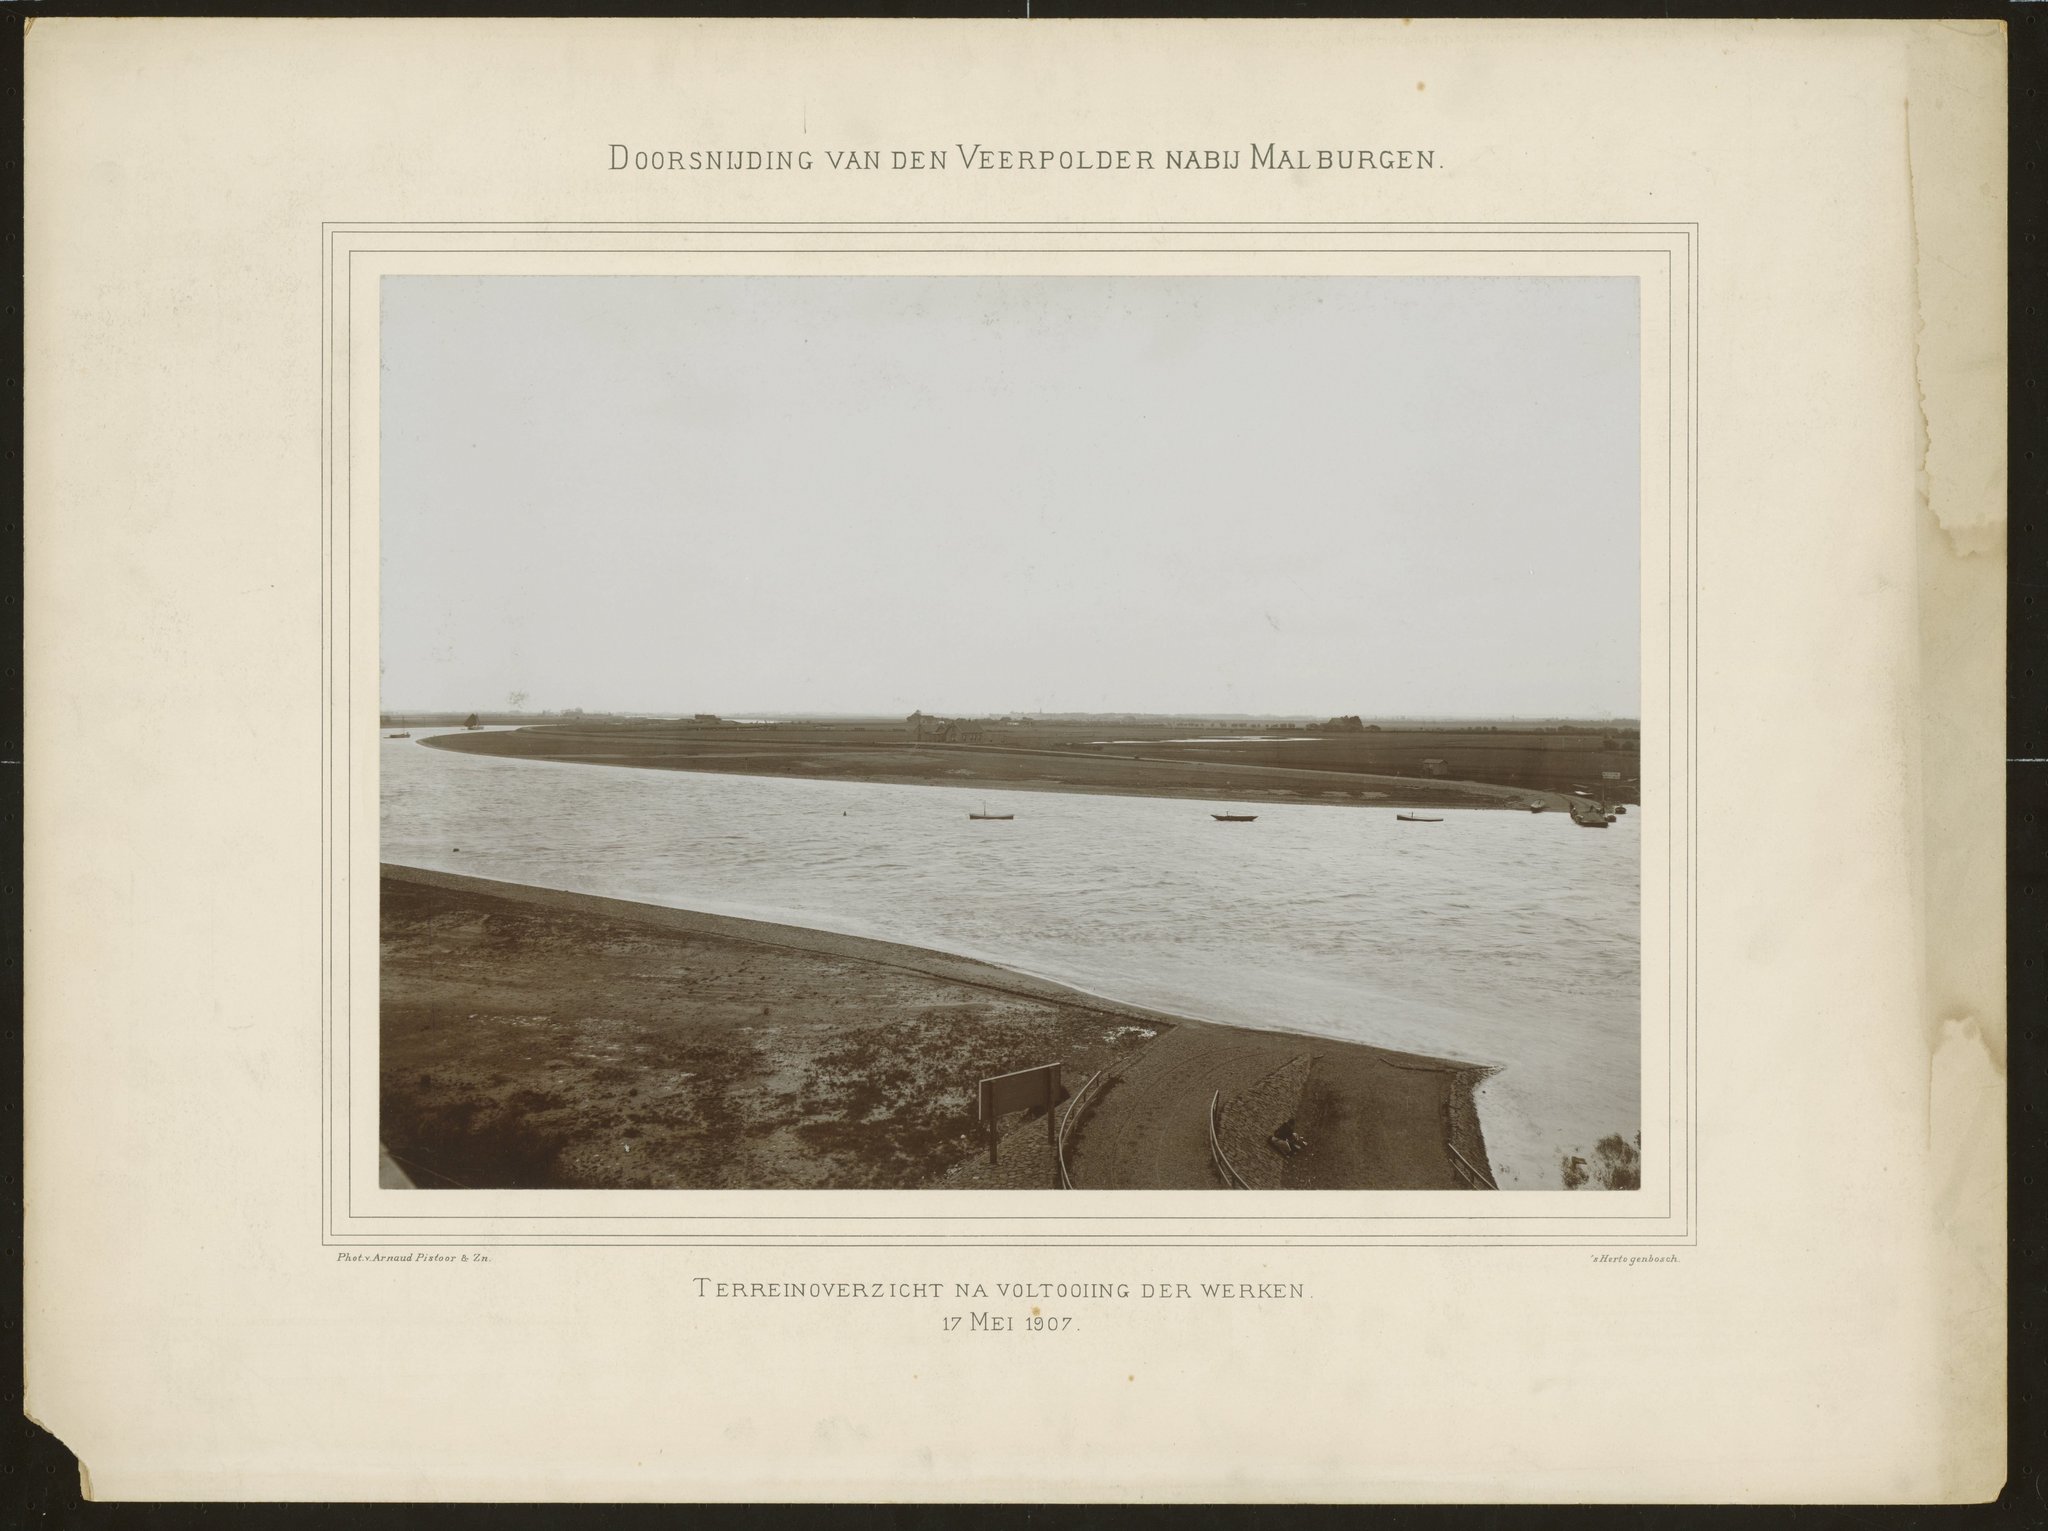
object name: photograph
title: Doorsnijding van den Veerpolder nabij Malburgen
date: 1907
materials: cardboard, paper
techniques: photography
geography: den bosch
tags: malburgen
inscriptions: date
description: Foto op karton. Opschrift: 'Terreinoverzicht na voltooing der werken, 17 mei 1907'. Gedateeerd en gesigneerd.